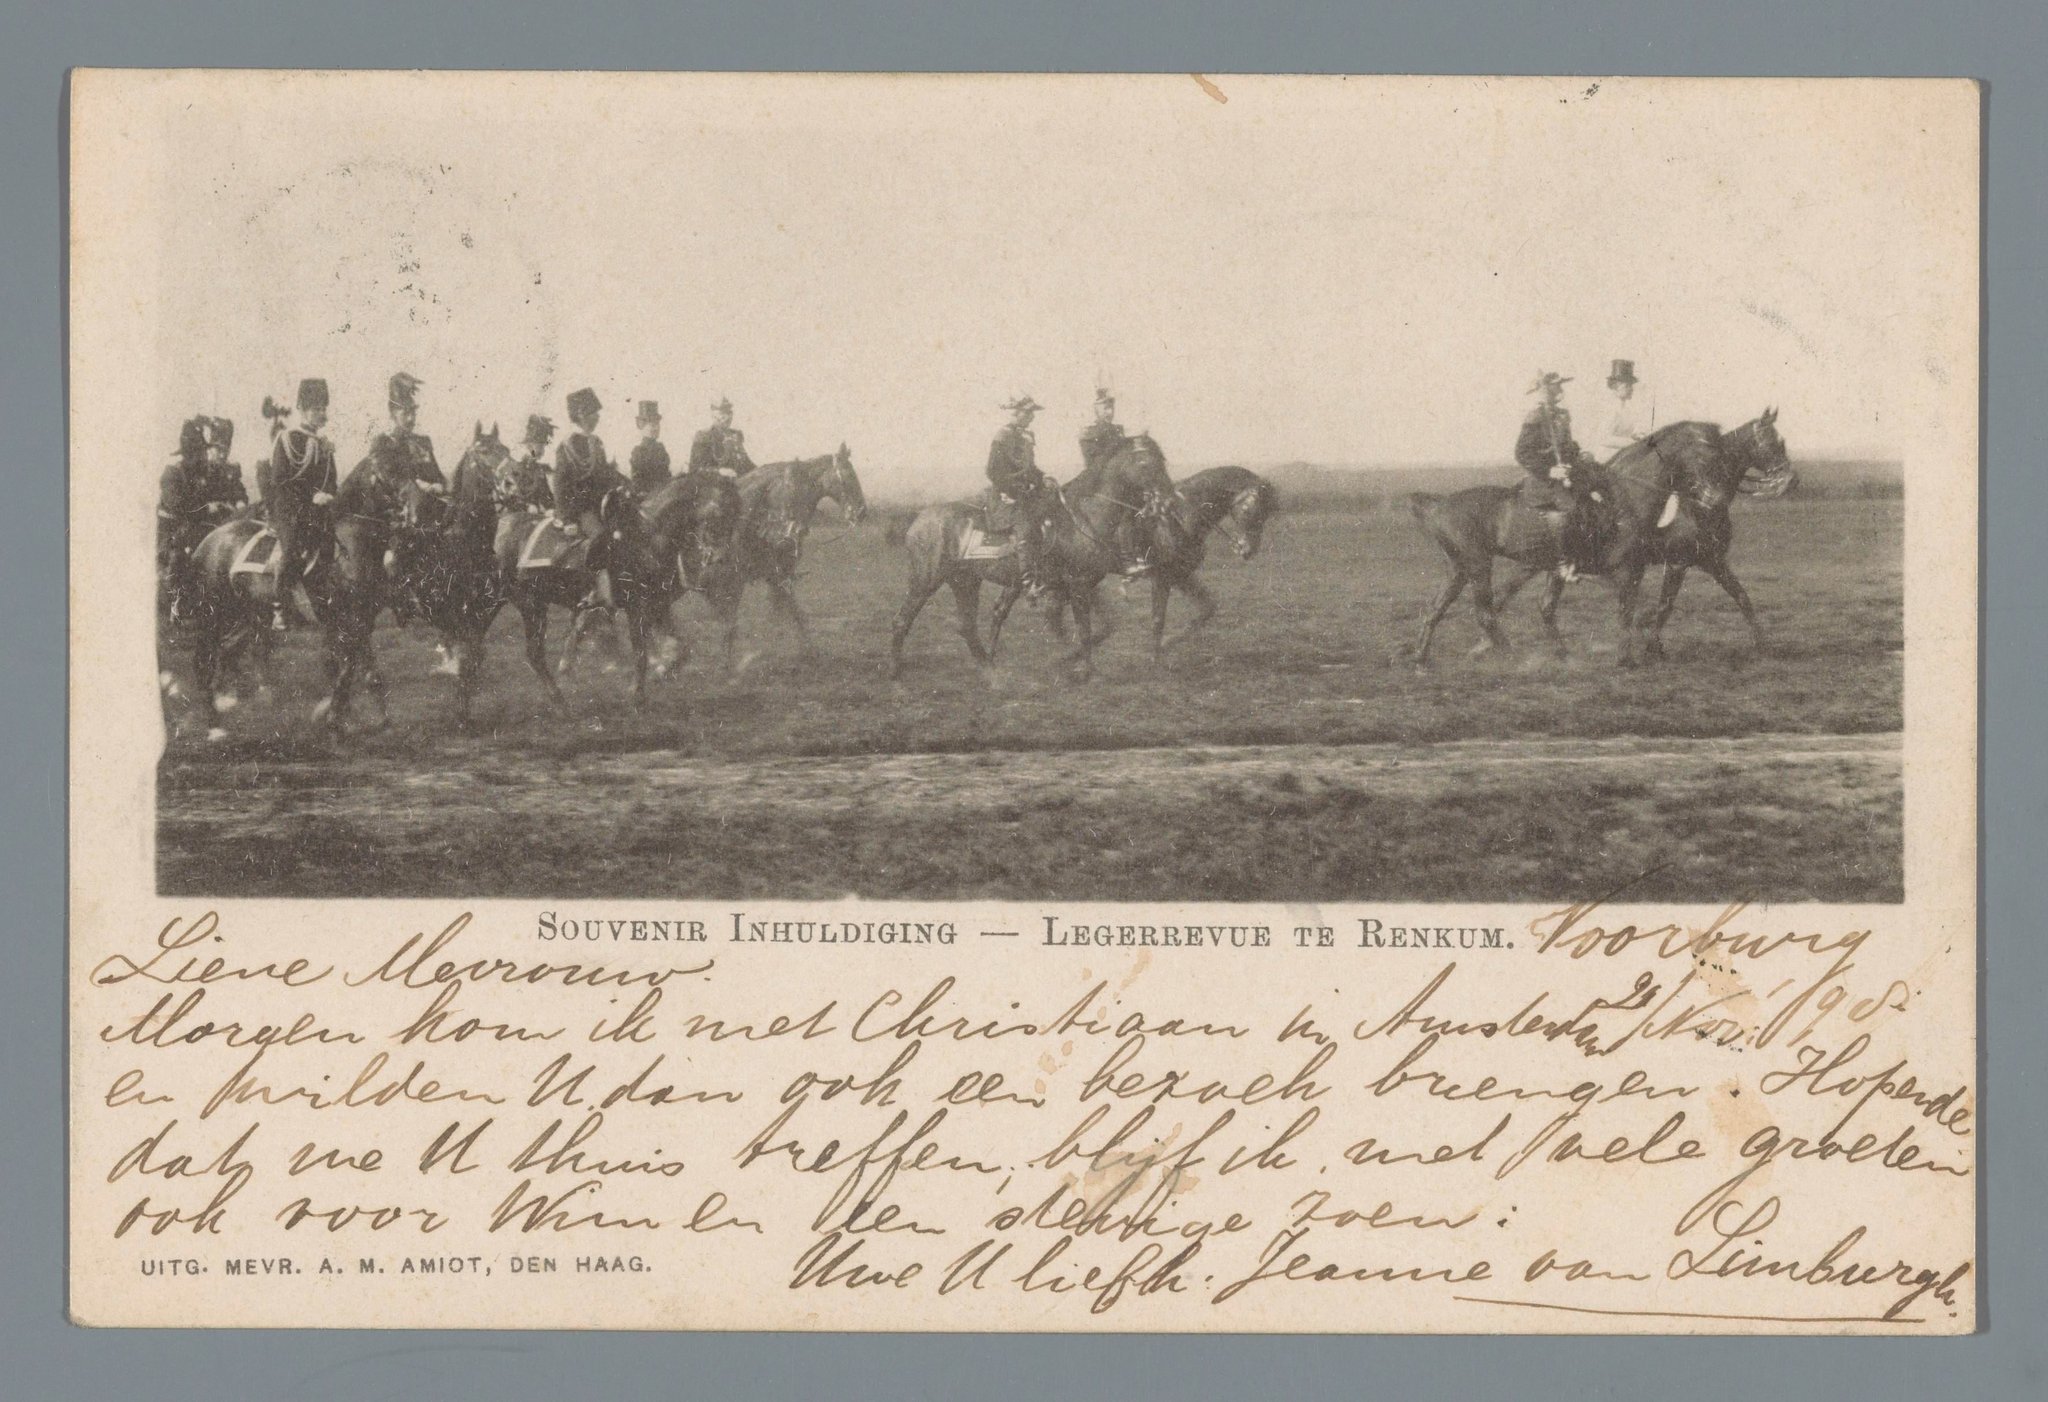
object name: ansichtkaart, prentbriefkaart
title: Souvenir inhuldiging - Legerrevue te Renkum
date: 1898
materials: cardboard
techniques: photograph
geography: the hague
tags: coronation of a ruler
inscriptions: postage stamp